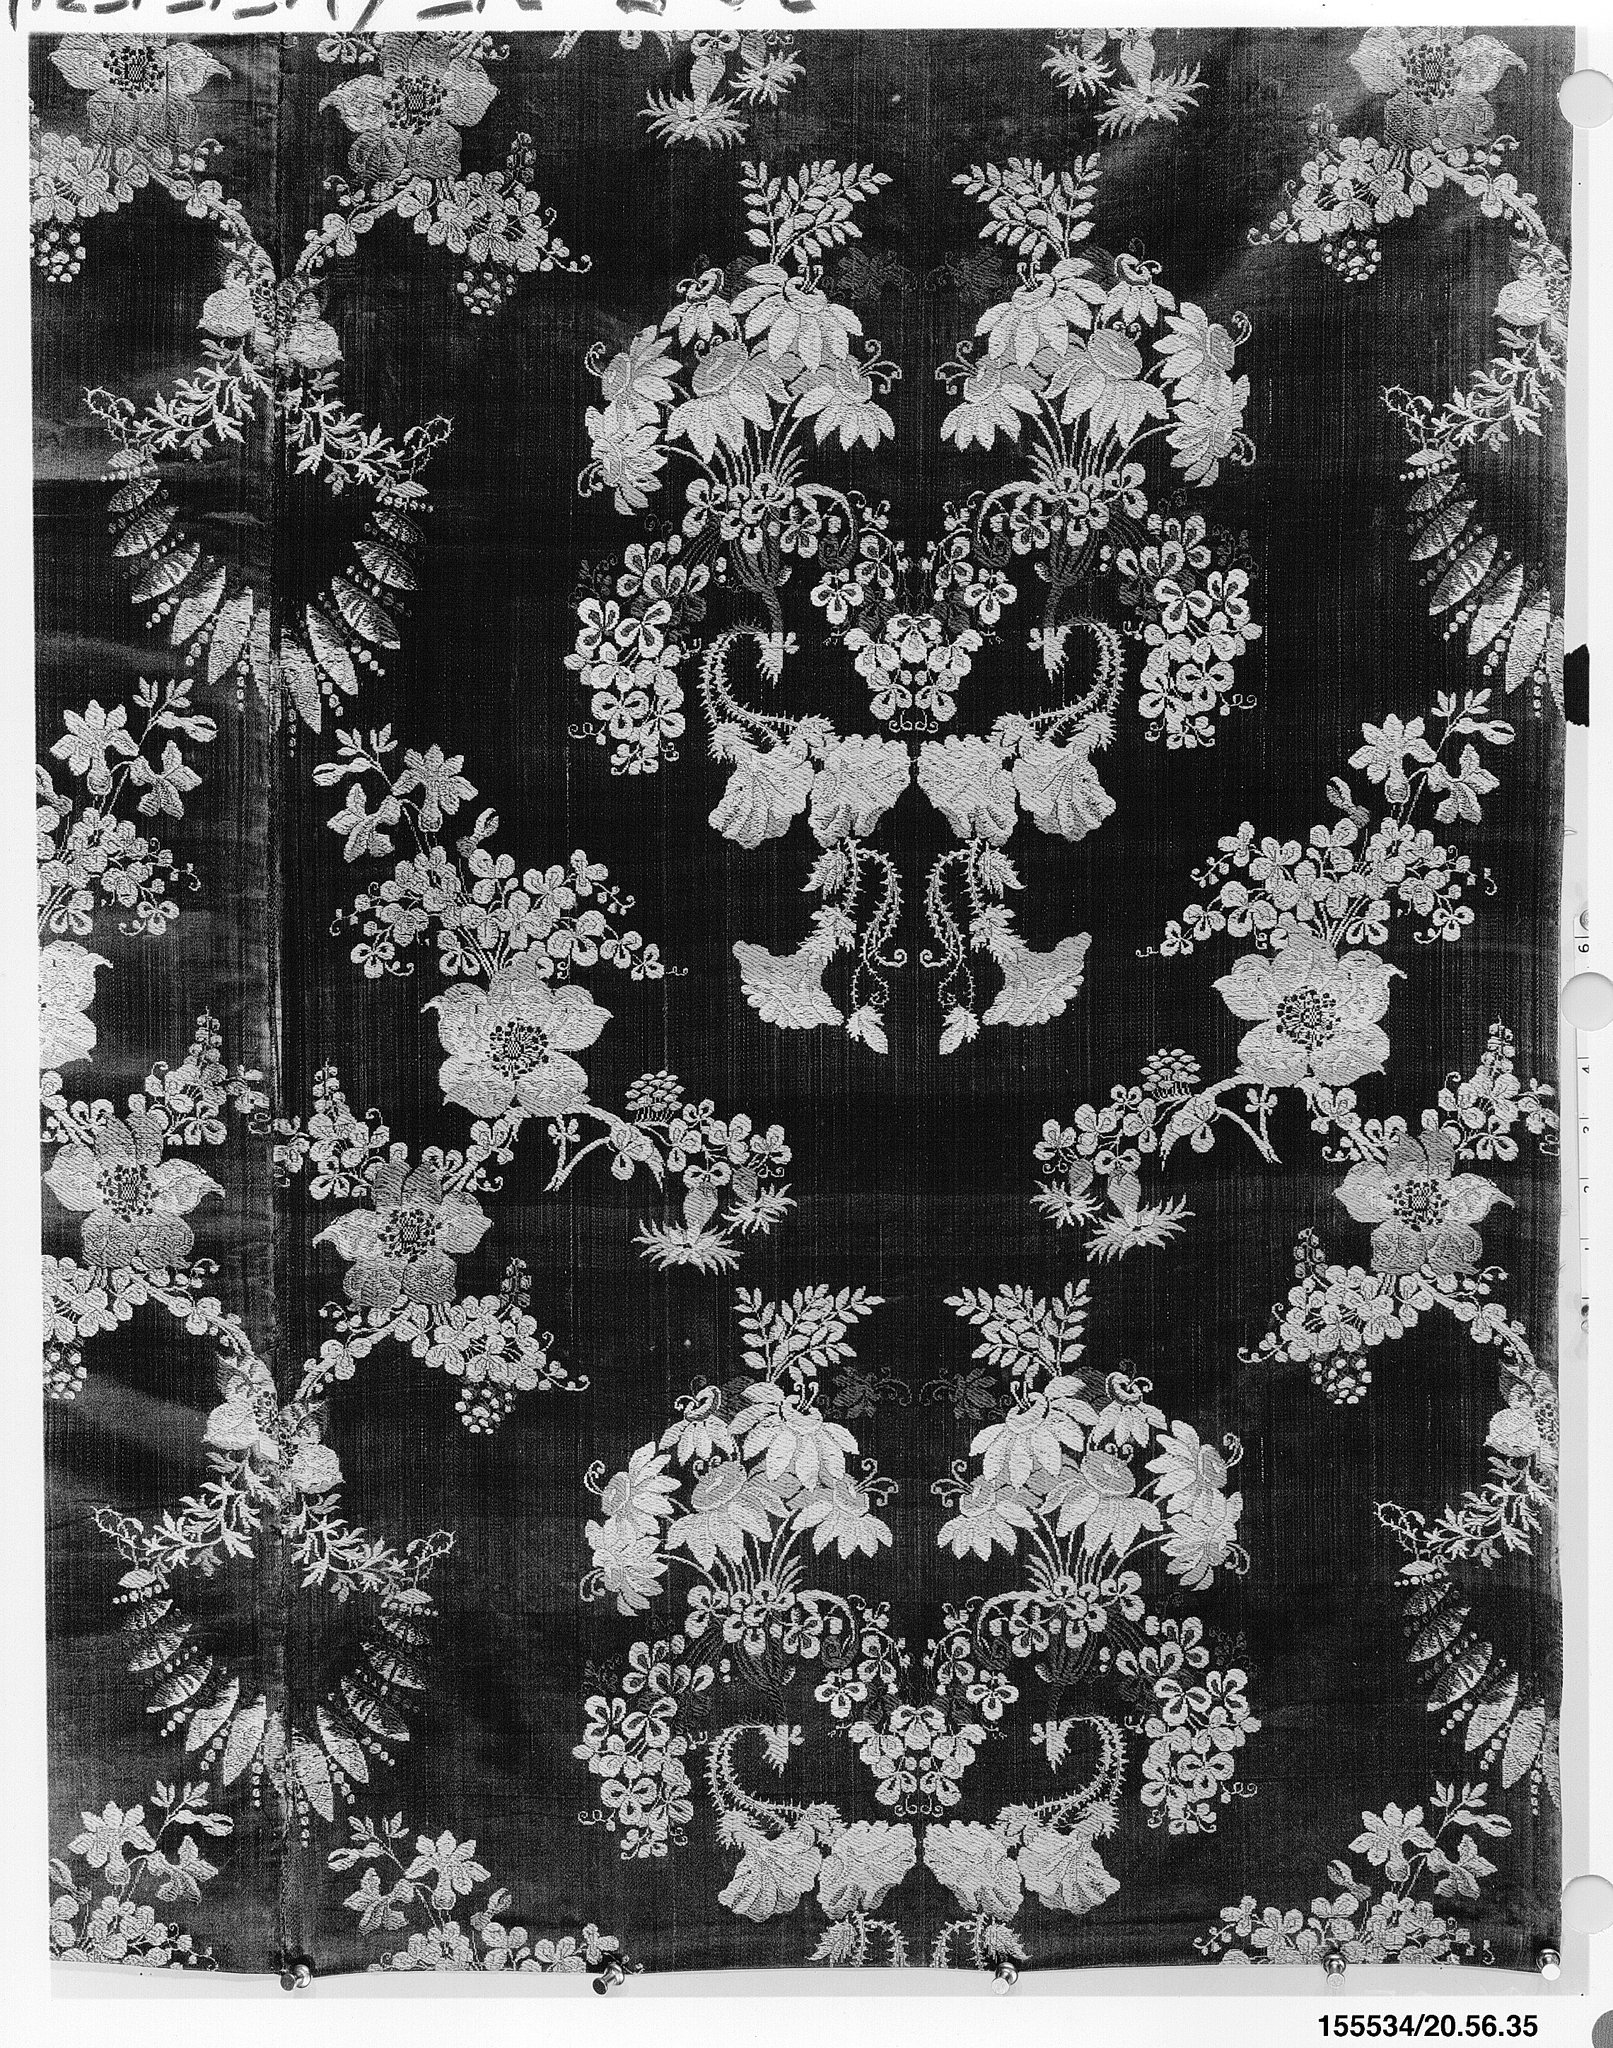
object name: piece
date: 1734-1766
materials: silk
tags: flowers,leaves